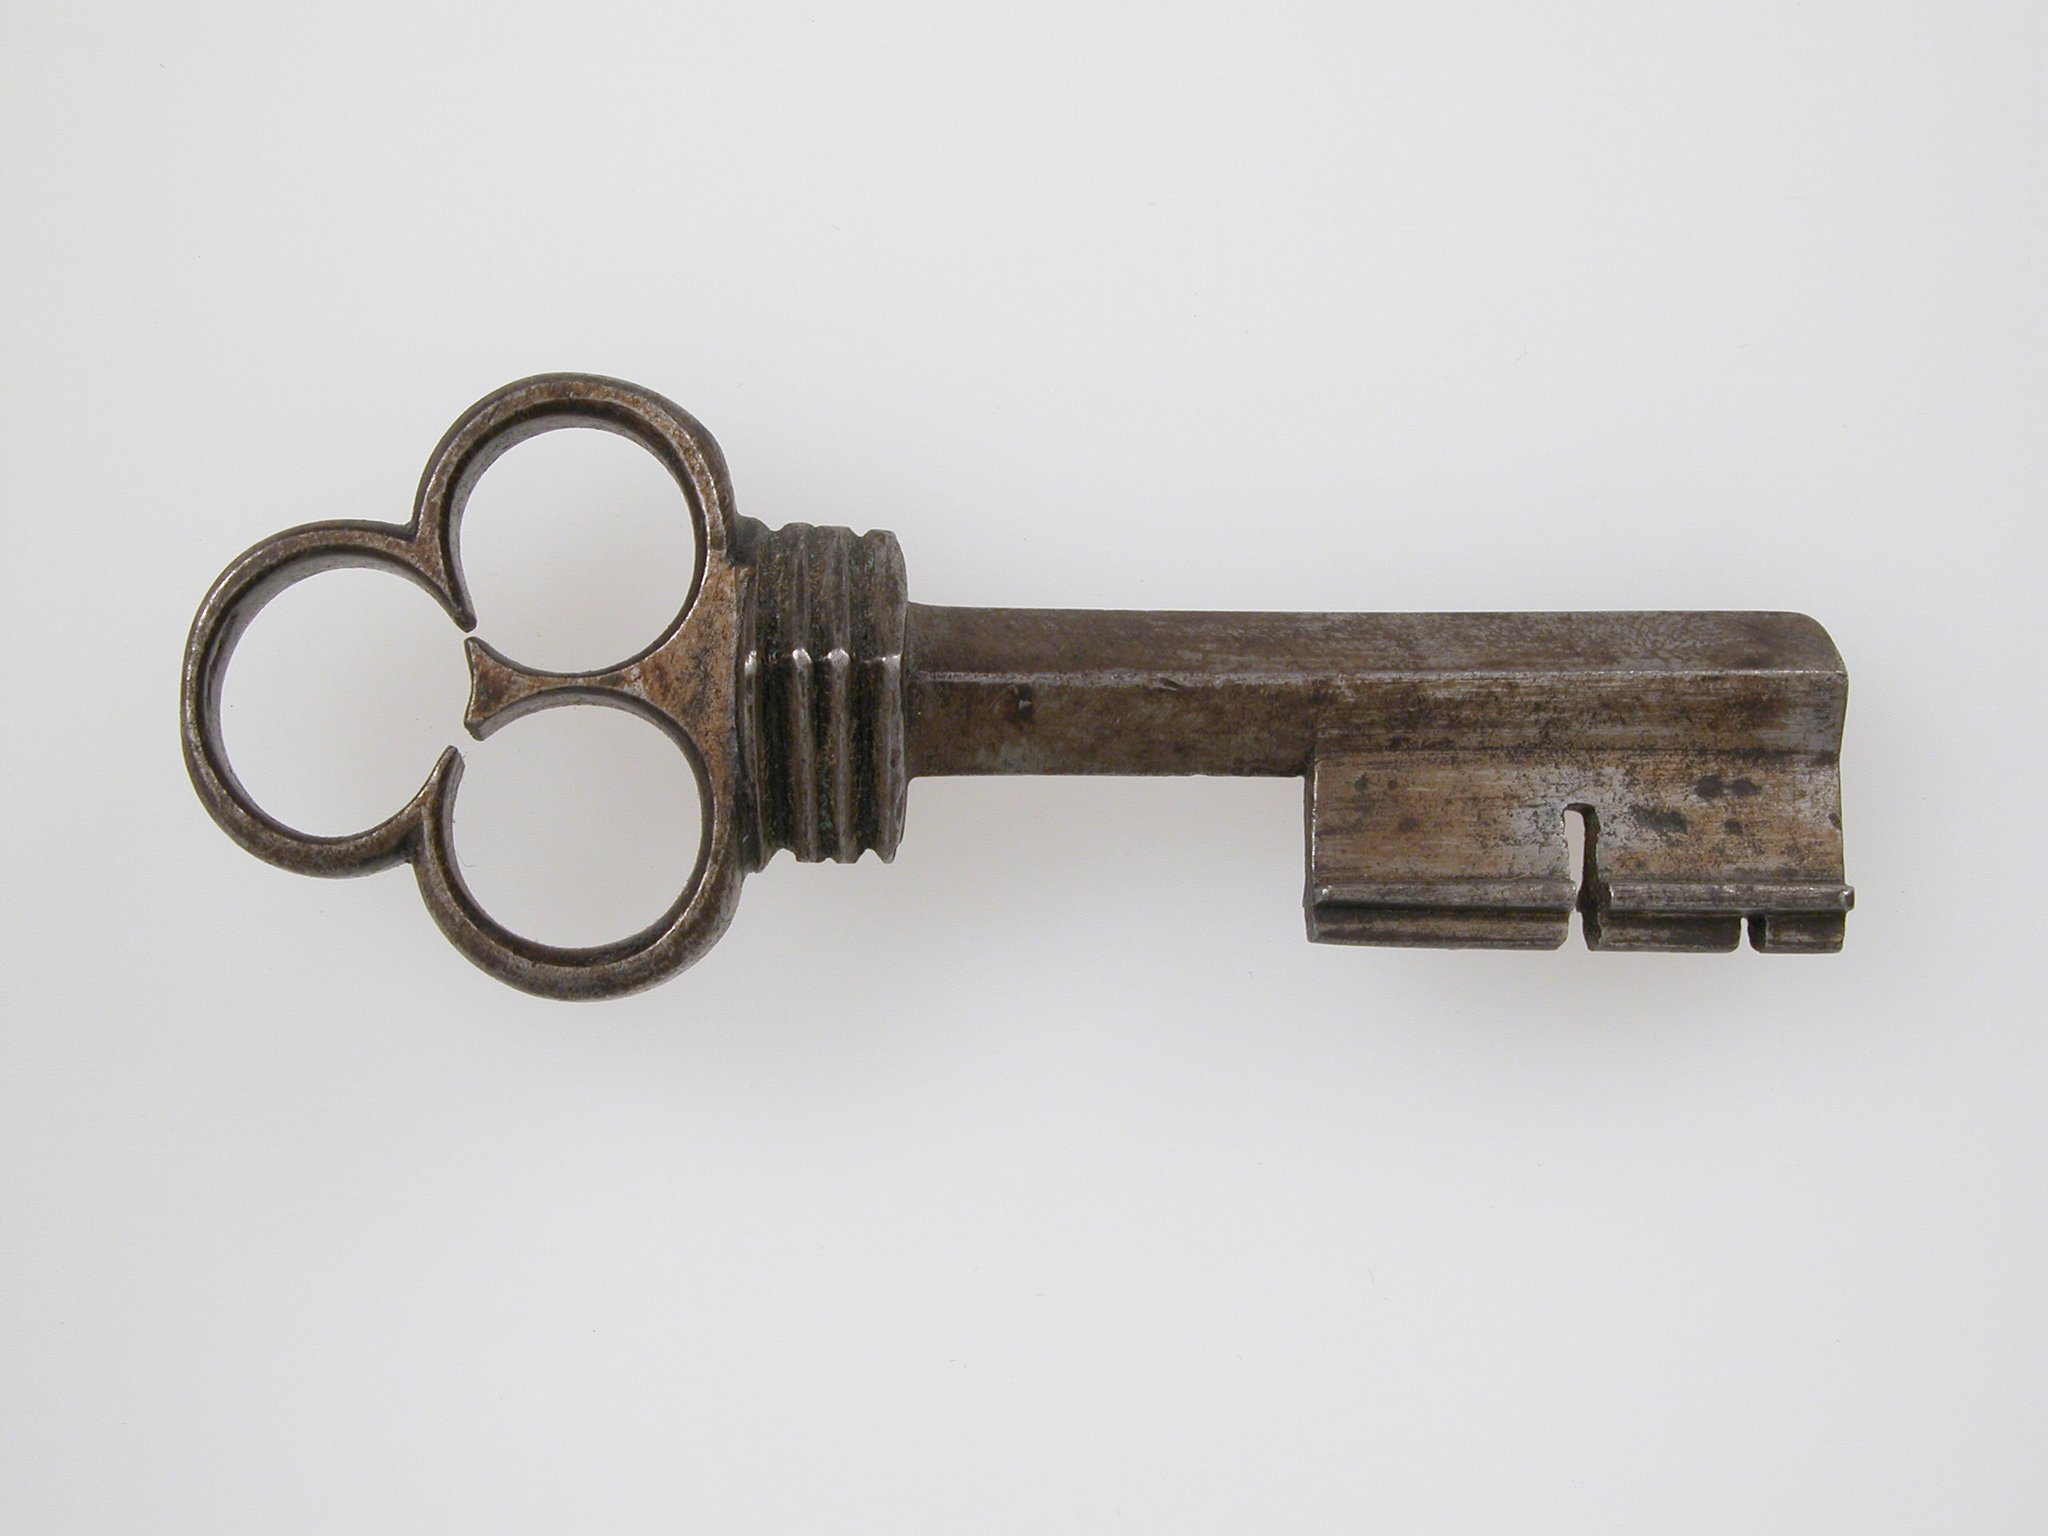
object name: key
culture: french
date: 1401-1433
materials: iron